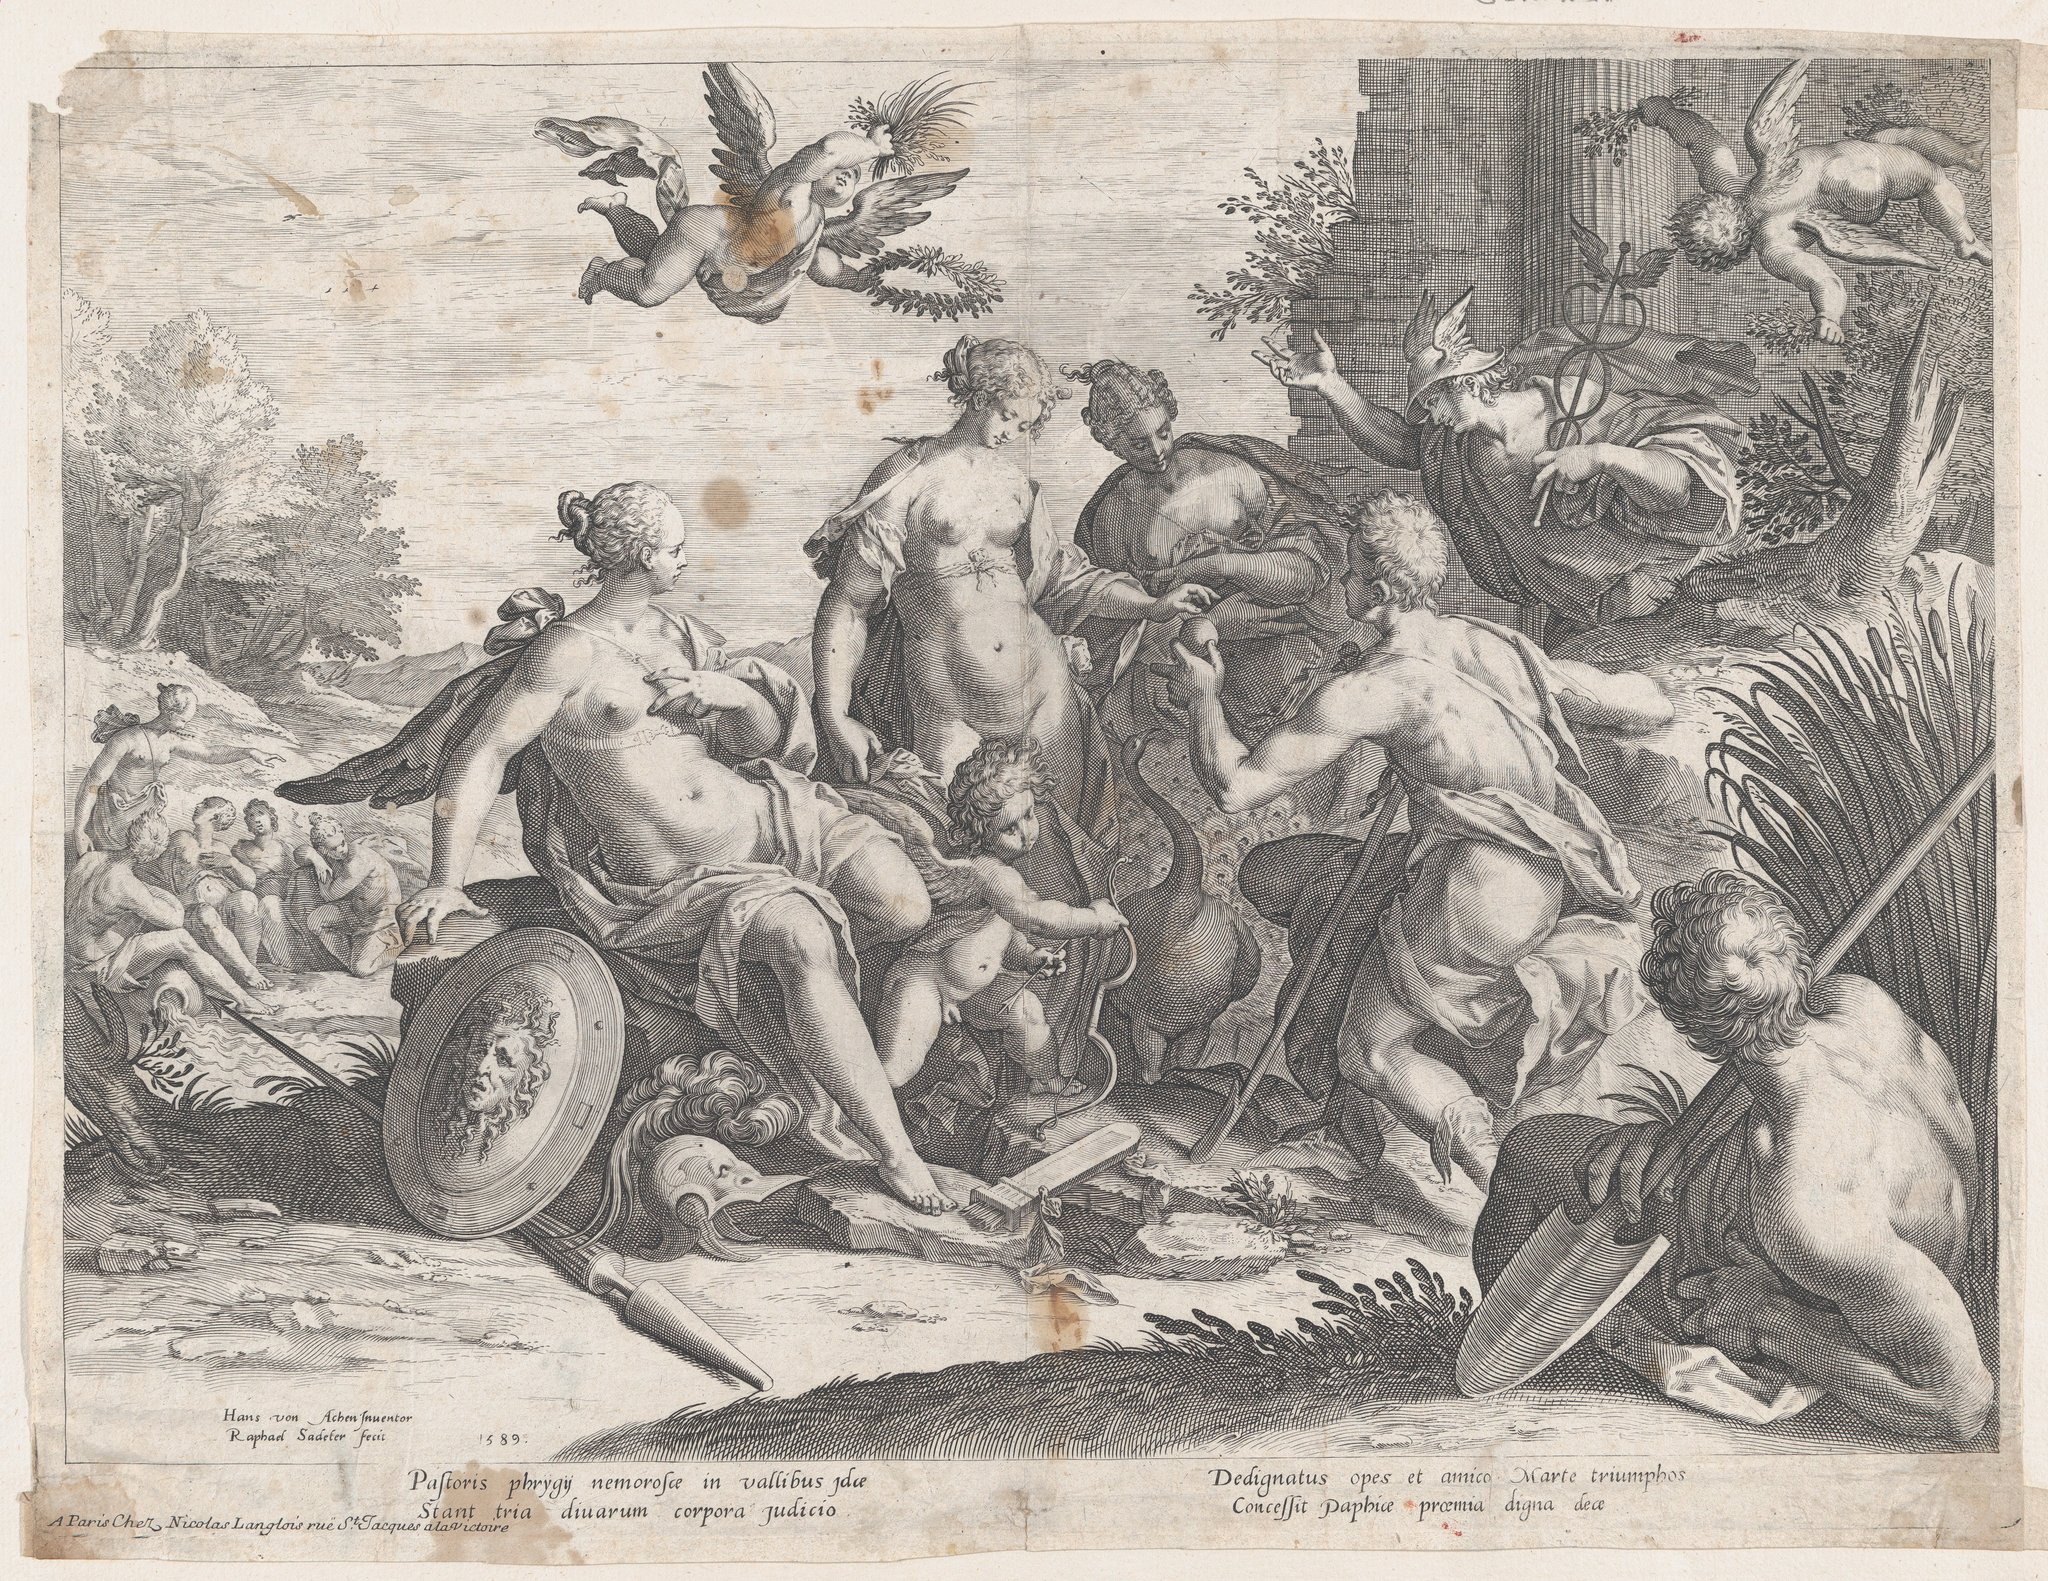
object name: print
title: The Judgement of Paris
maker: raphael sadeler i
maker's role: artist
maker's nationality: netherlandish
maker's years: 1560-1628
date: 1589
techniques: engraving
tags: shields,male nudes,female nudes,peacocks,paris